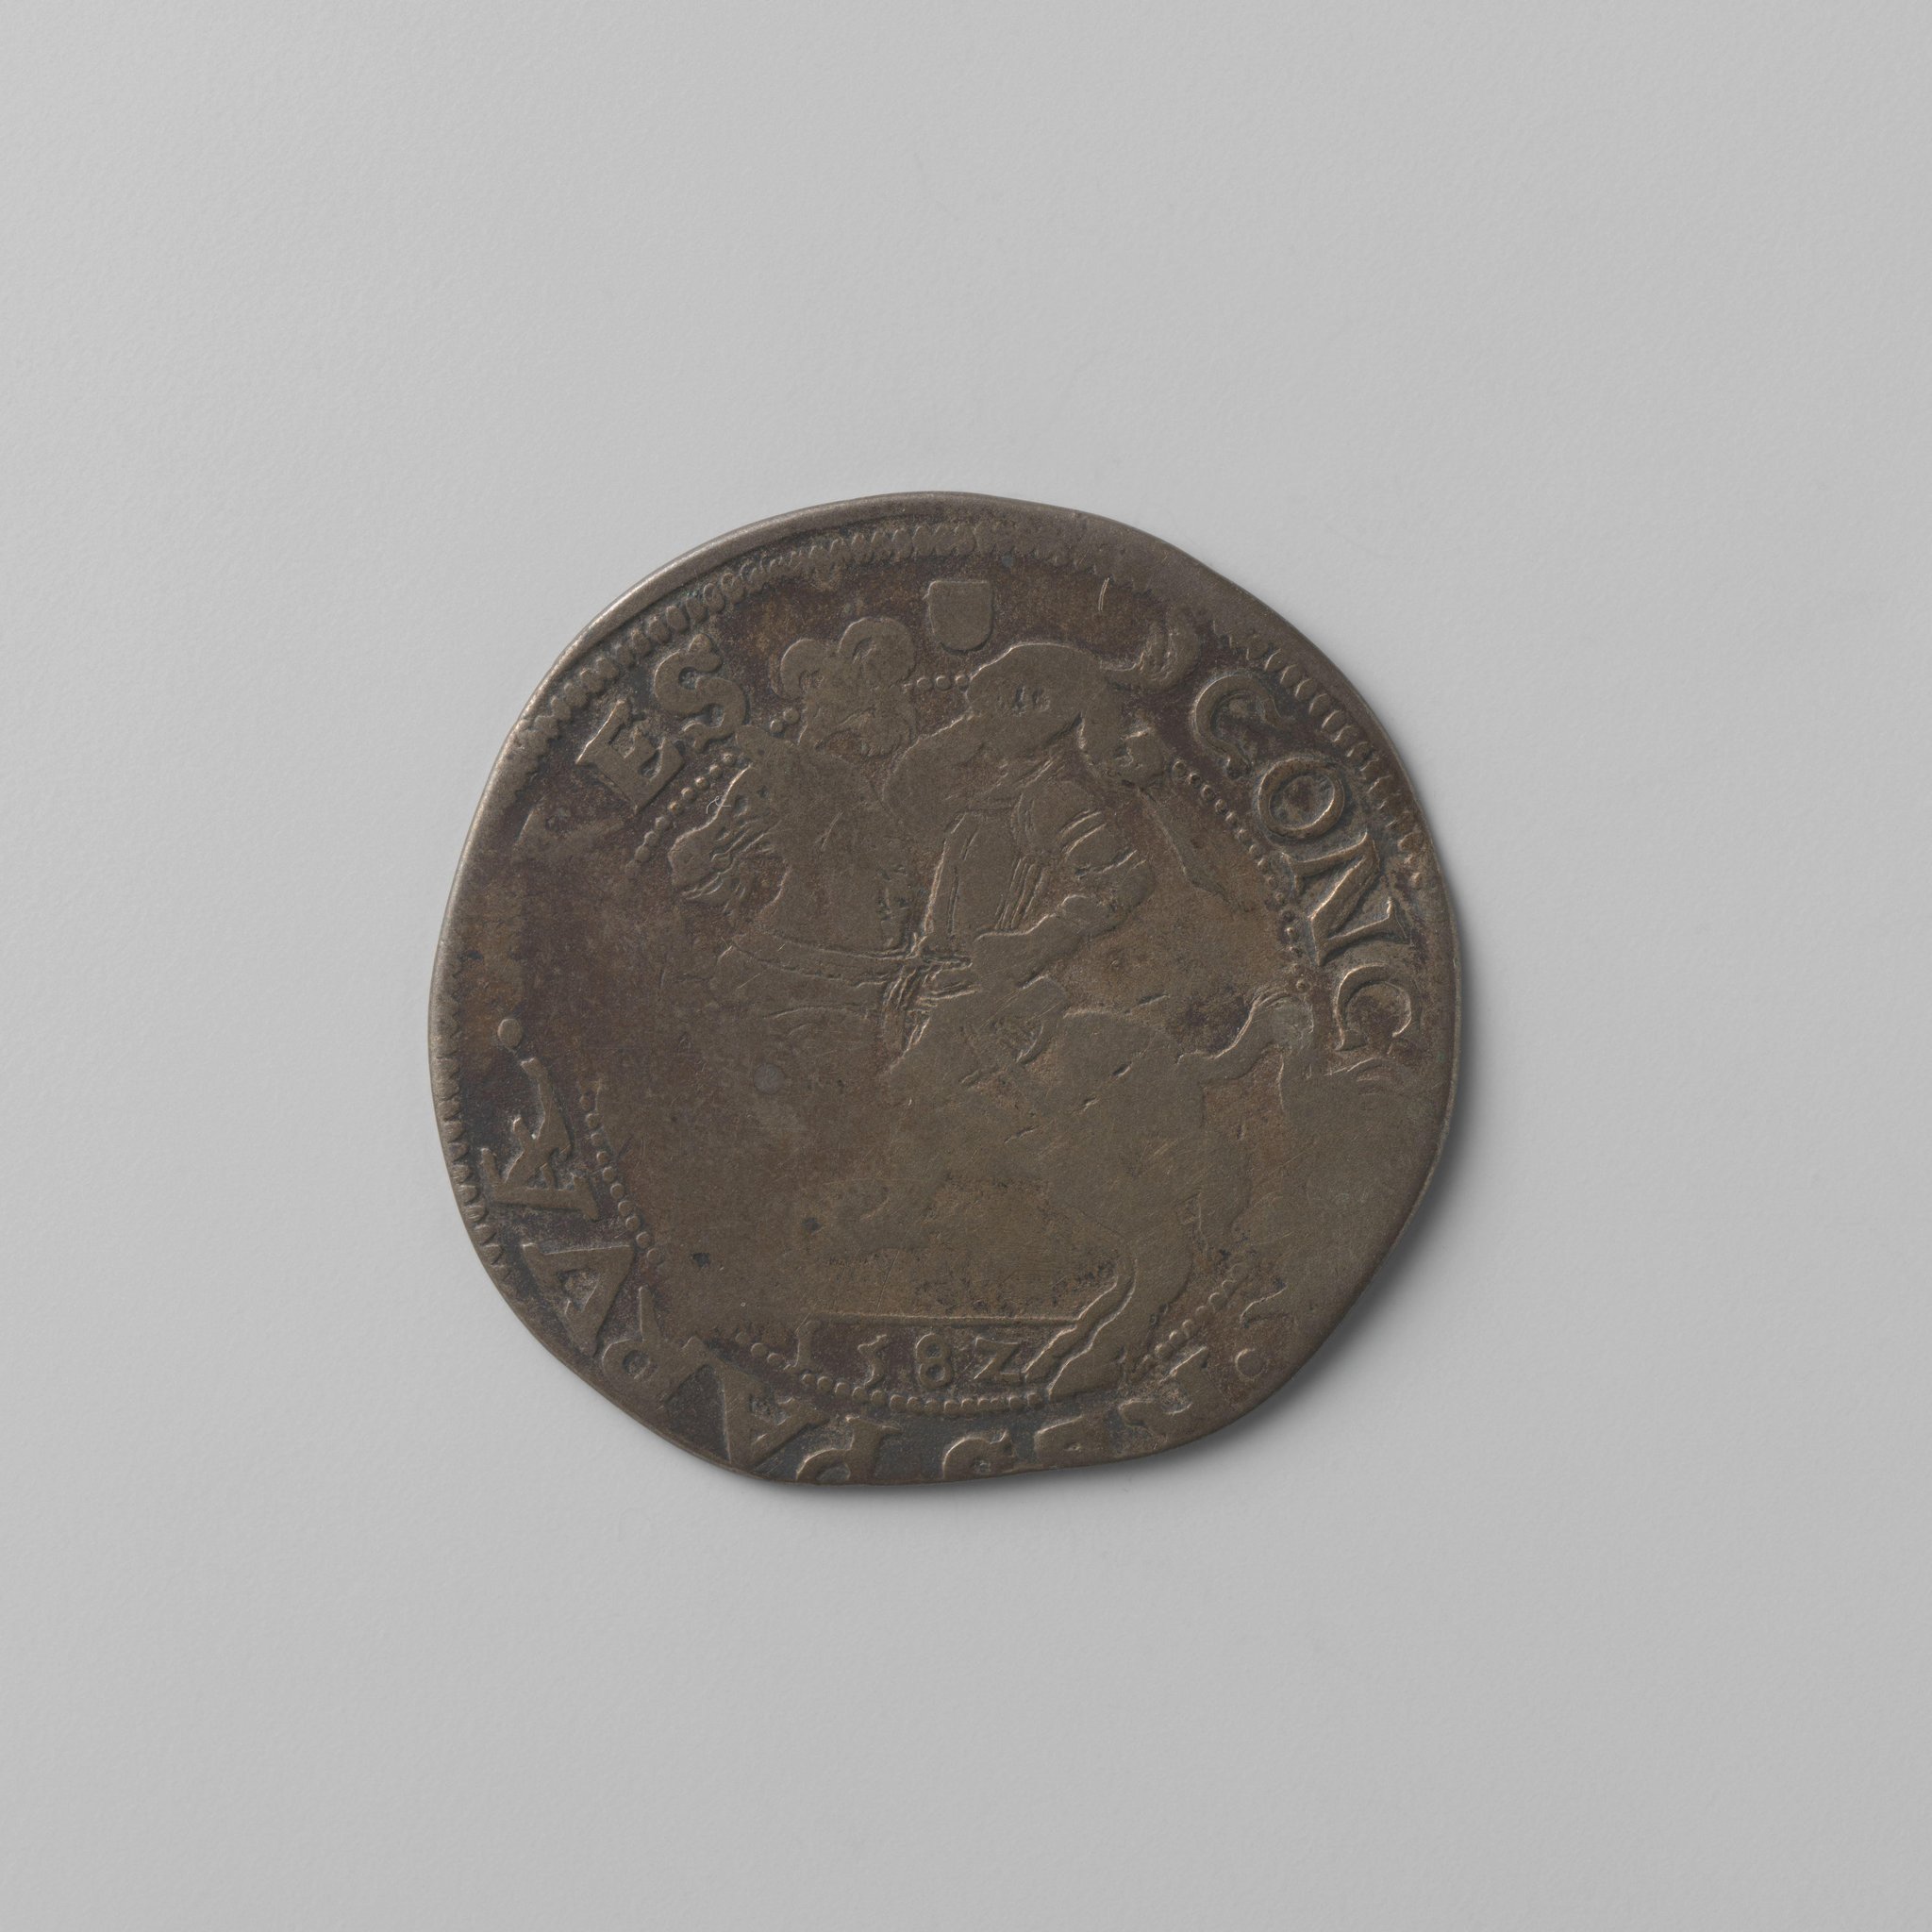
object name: coin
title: Utrecht, snaphaanschelling, 1582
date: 1582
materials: silver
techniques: striking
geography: utrecht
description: Zilveren munt. Voorzijde: op lang versierd kruis wapenschild van Utrecht. Keerzijde: geharnaste ruiter rijdend naar links, in afsnede verkort jaartal 82.